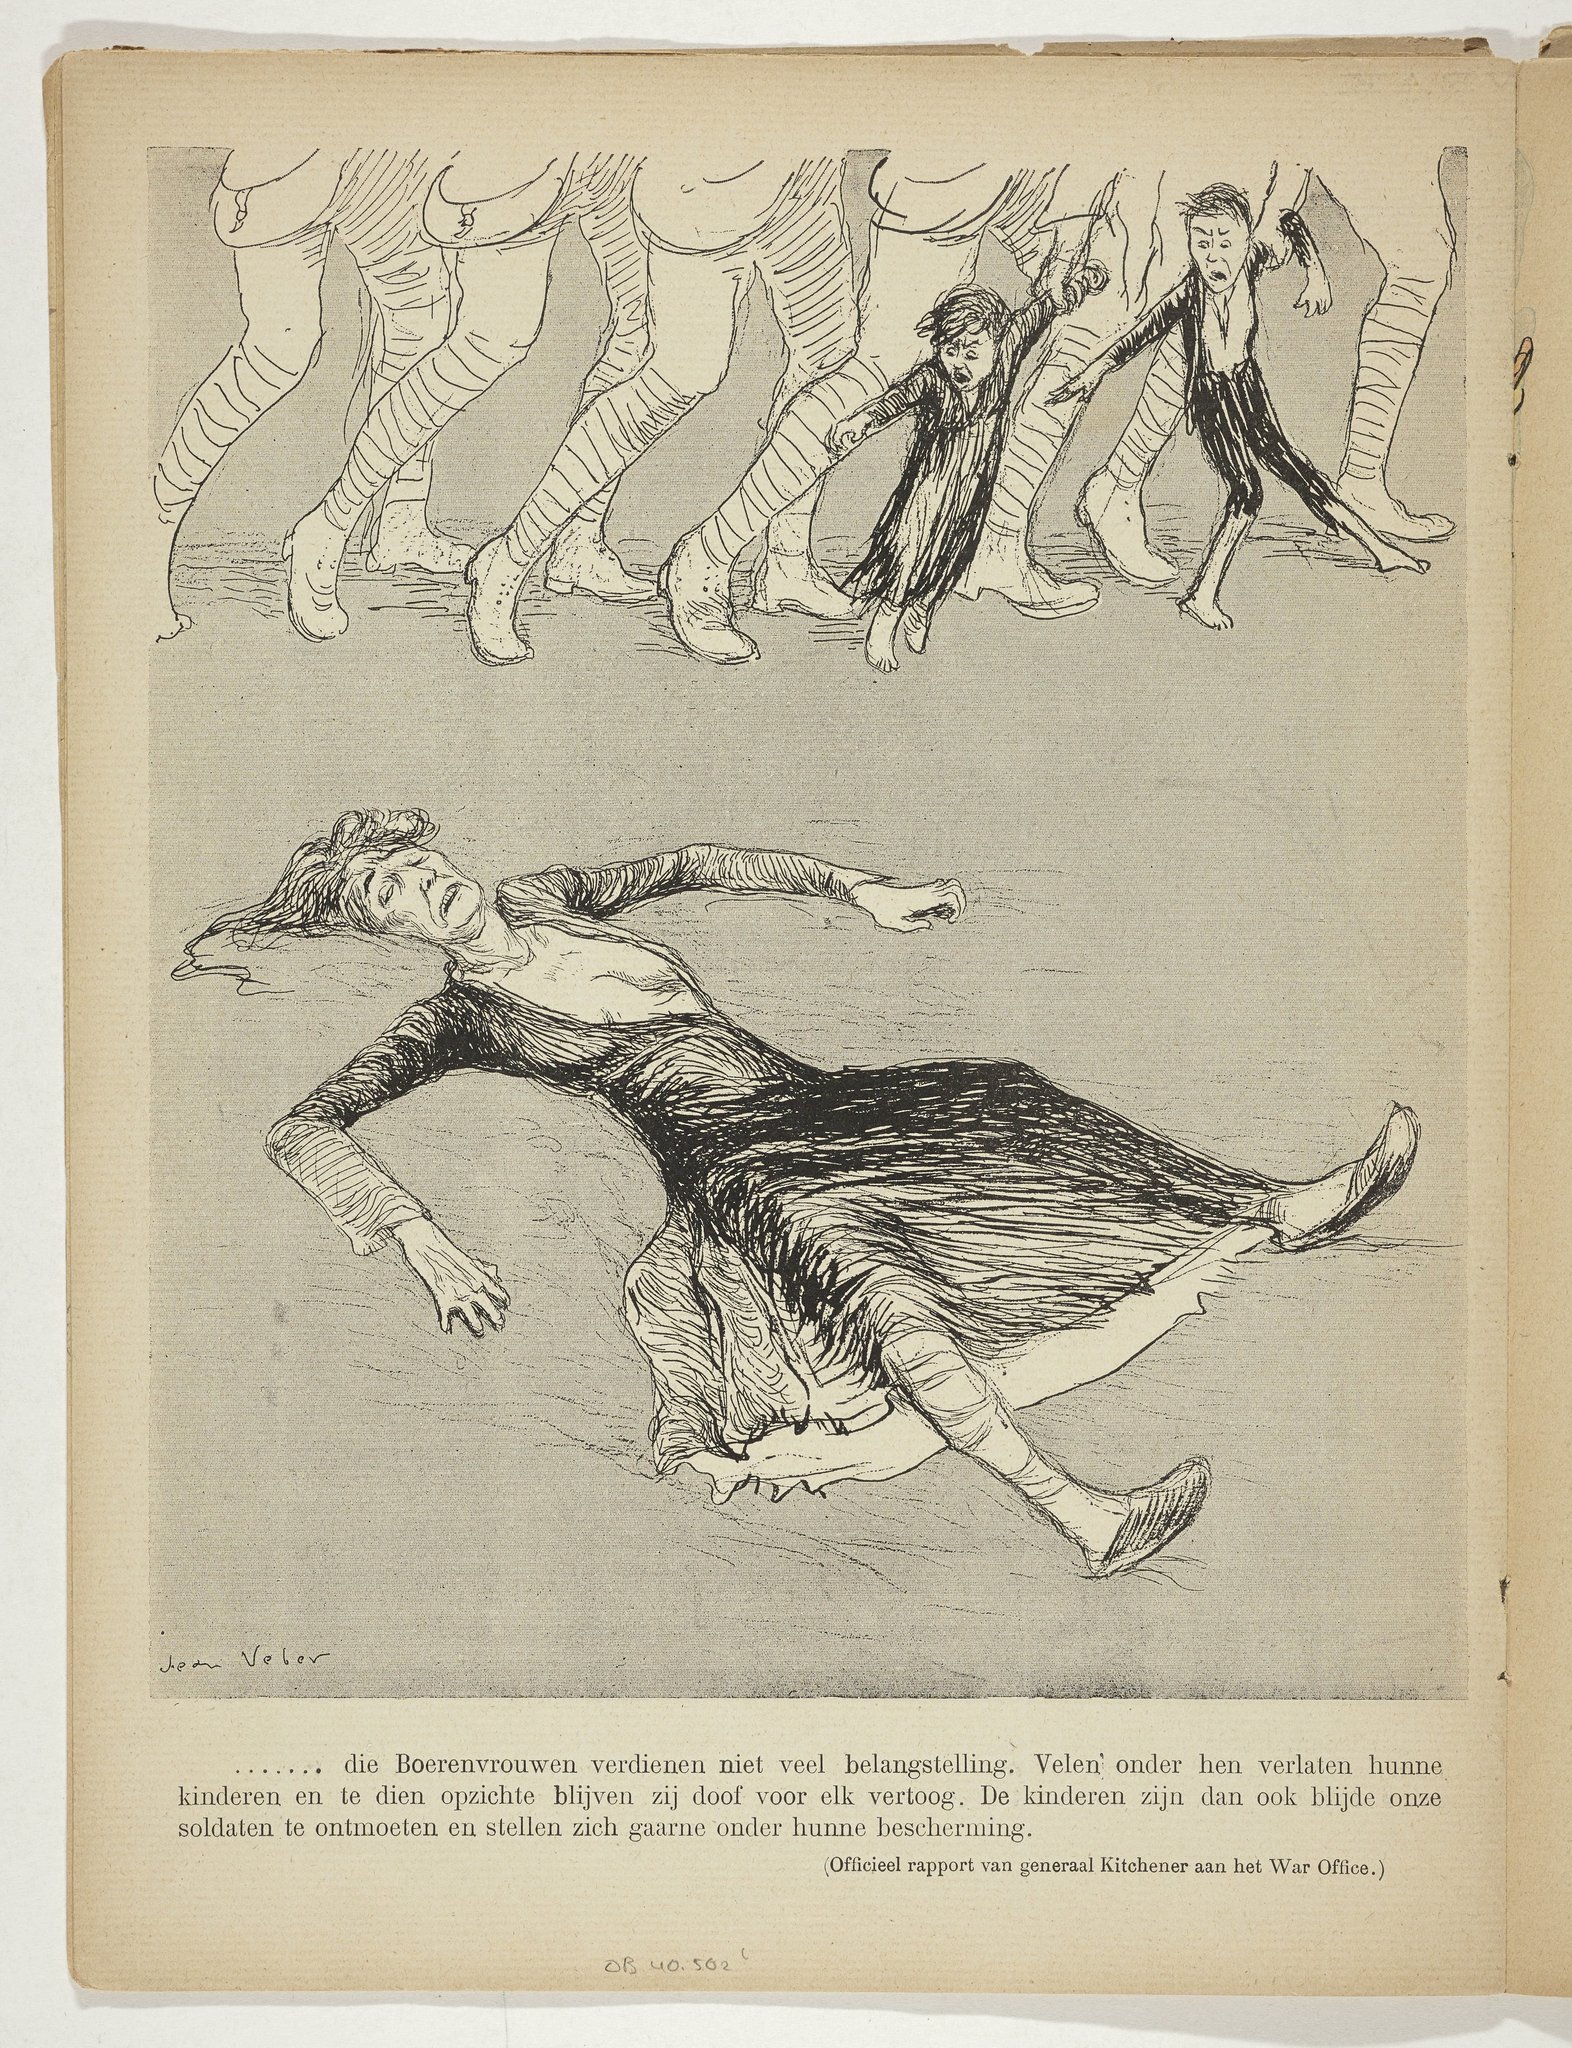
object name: page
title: Twee Boerenkinderen worden door Britse soldaten weggevoerd, hun moeder ligt (dood?) op de grond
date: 1901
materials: paper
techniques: letterpress printing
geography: amsterdam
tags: horrors of war, the soldier; the soldier's life, political caricatures and satires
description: Prent maakt deel uit van een tijdschrift met spotprenten op de Tweede Boerenoorlog. Met vierregelig onderschrift: ....... die Boerenvrouwen verdienen niet veel belangstelling. Velen onder hen verlaten hunne kinderen ... en stellen zich gaarne onder hunne bescherming. (Officieel rapport van generaal Kitchener aan het War Office.).